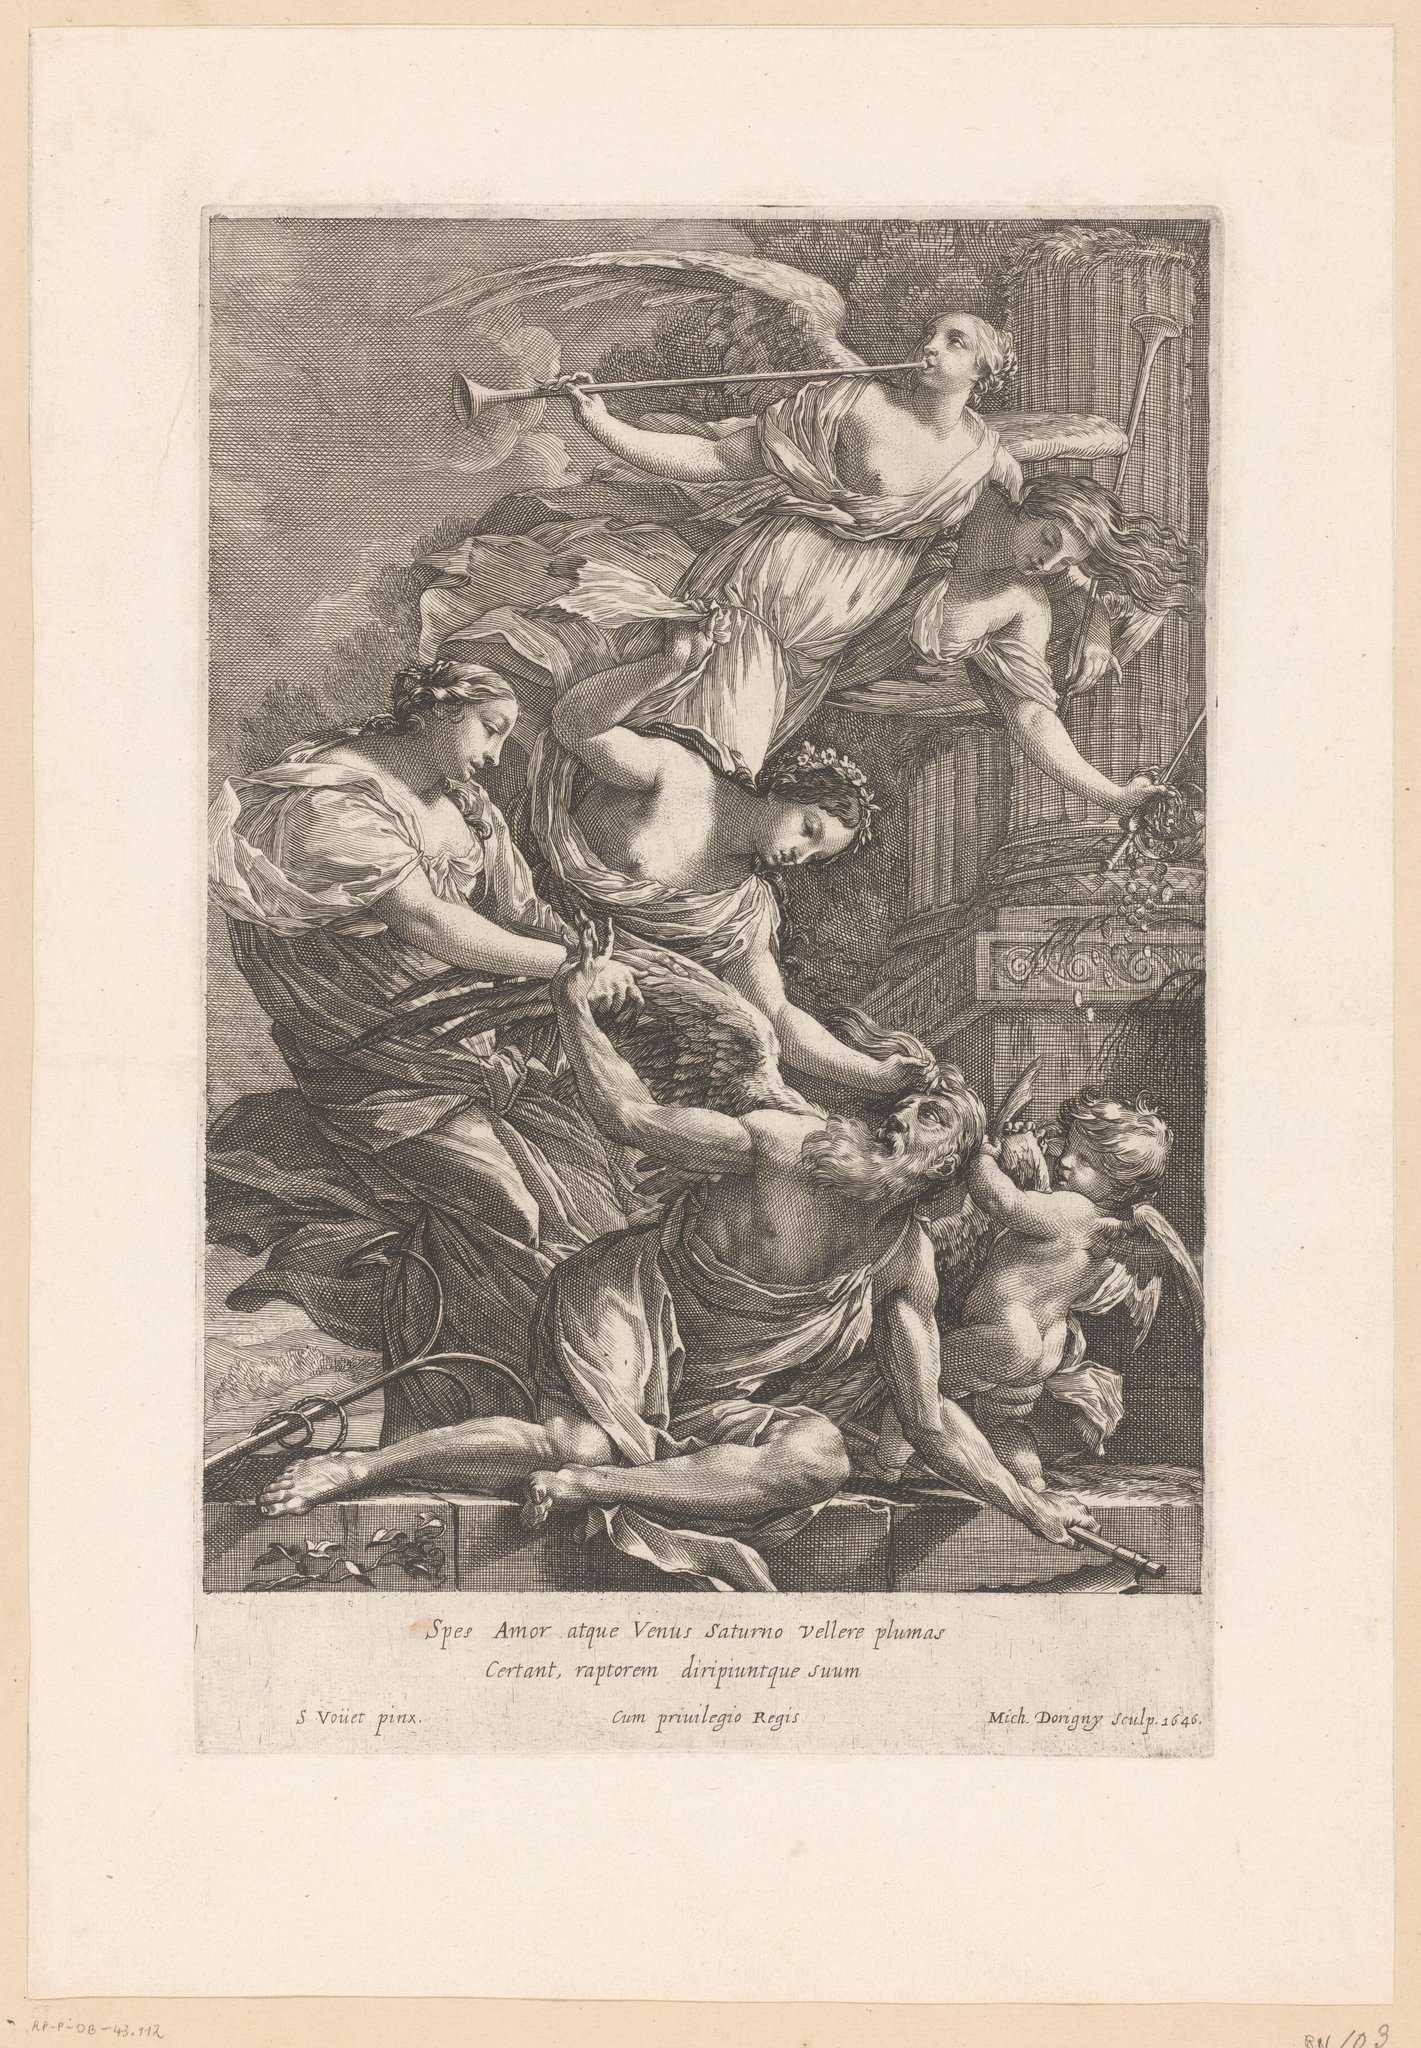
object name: print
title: Tijd overwonnen door Amor, Venus en de Hoop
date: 1646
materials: paper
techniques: engraving, etching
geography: france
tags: hope; 'speranza', 'speranza delle fatiche' (ripa), (story of) venus (aphrodite), cupids: 'amores', 'amoretti', 'putti', father time, man with wings and scythe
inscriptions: watermark, collector's mark: Lugt 240